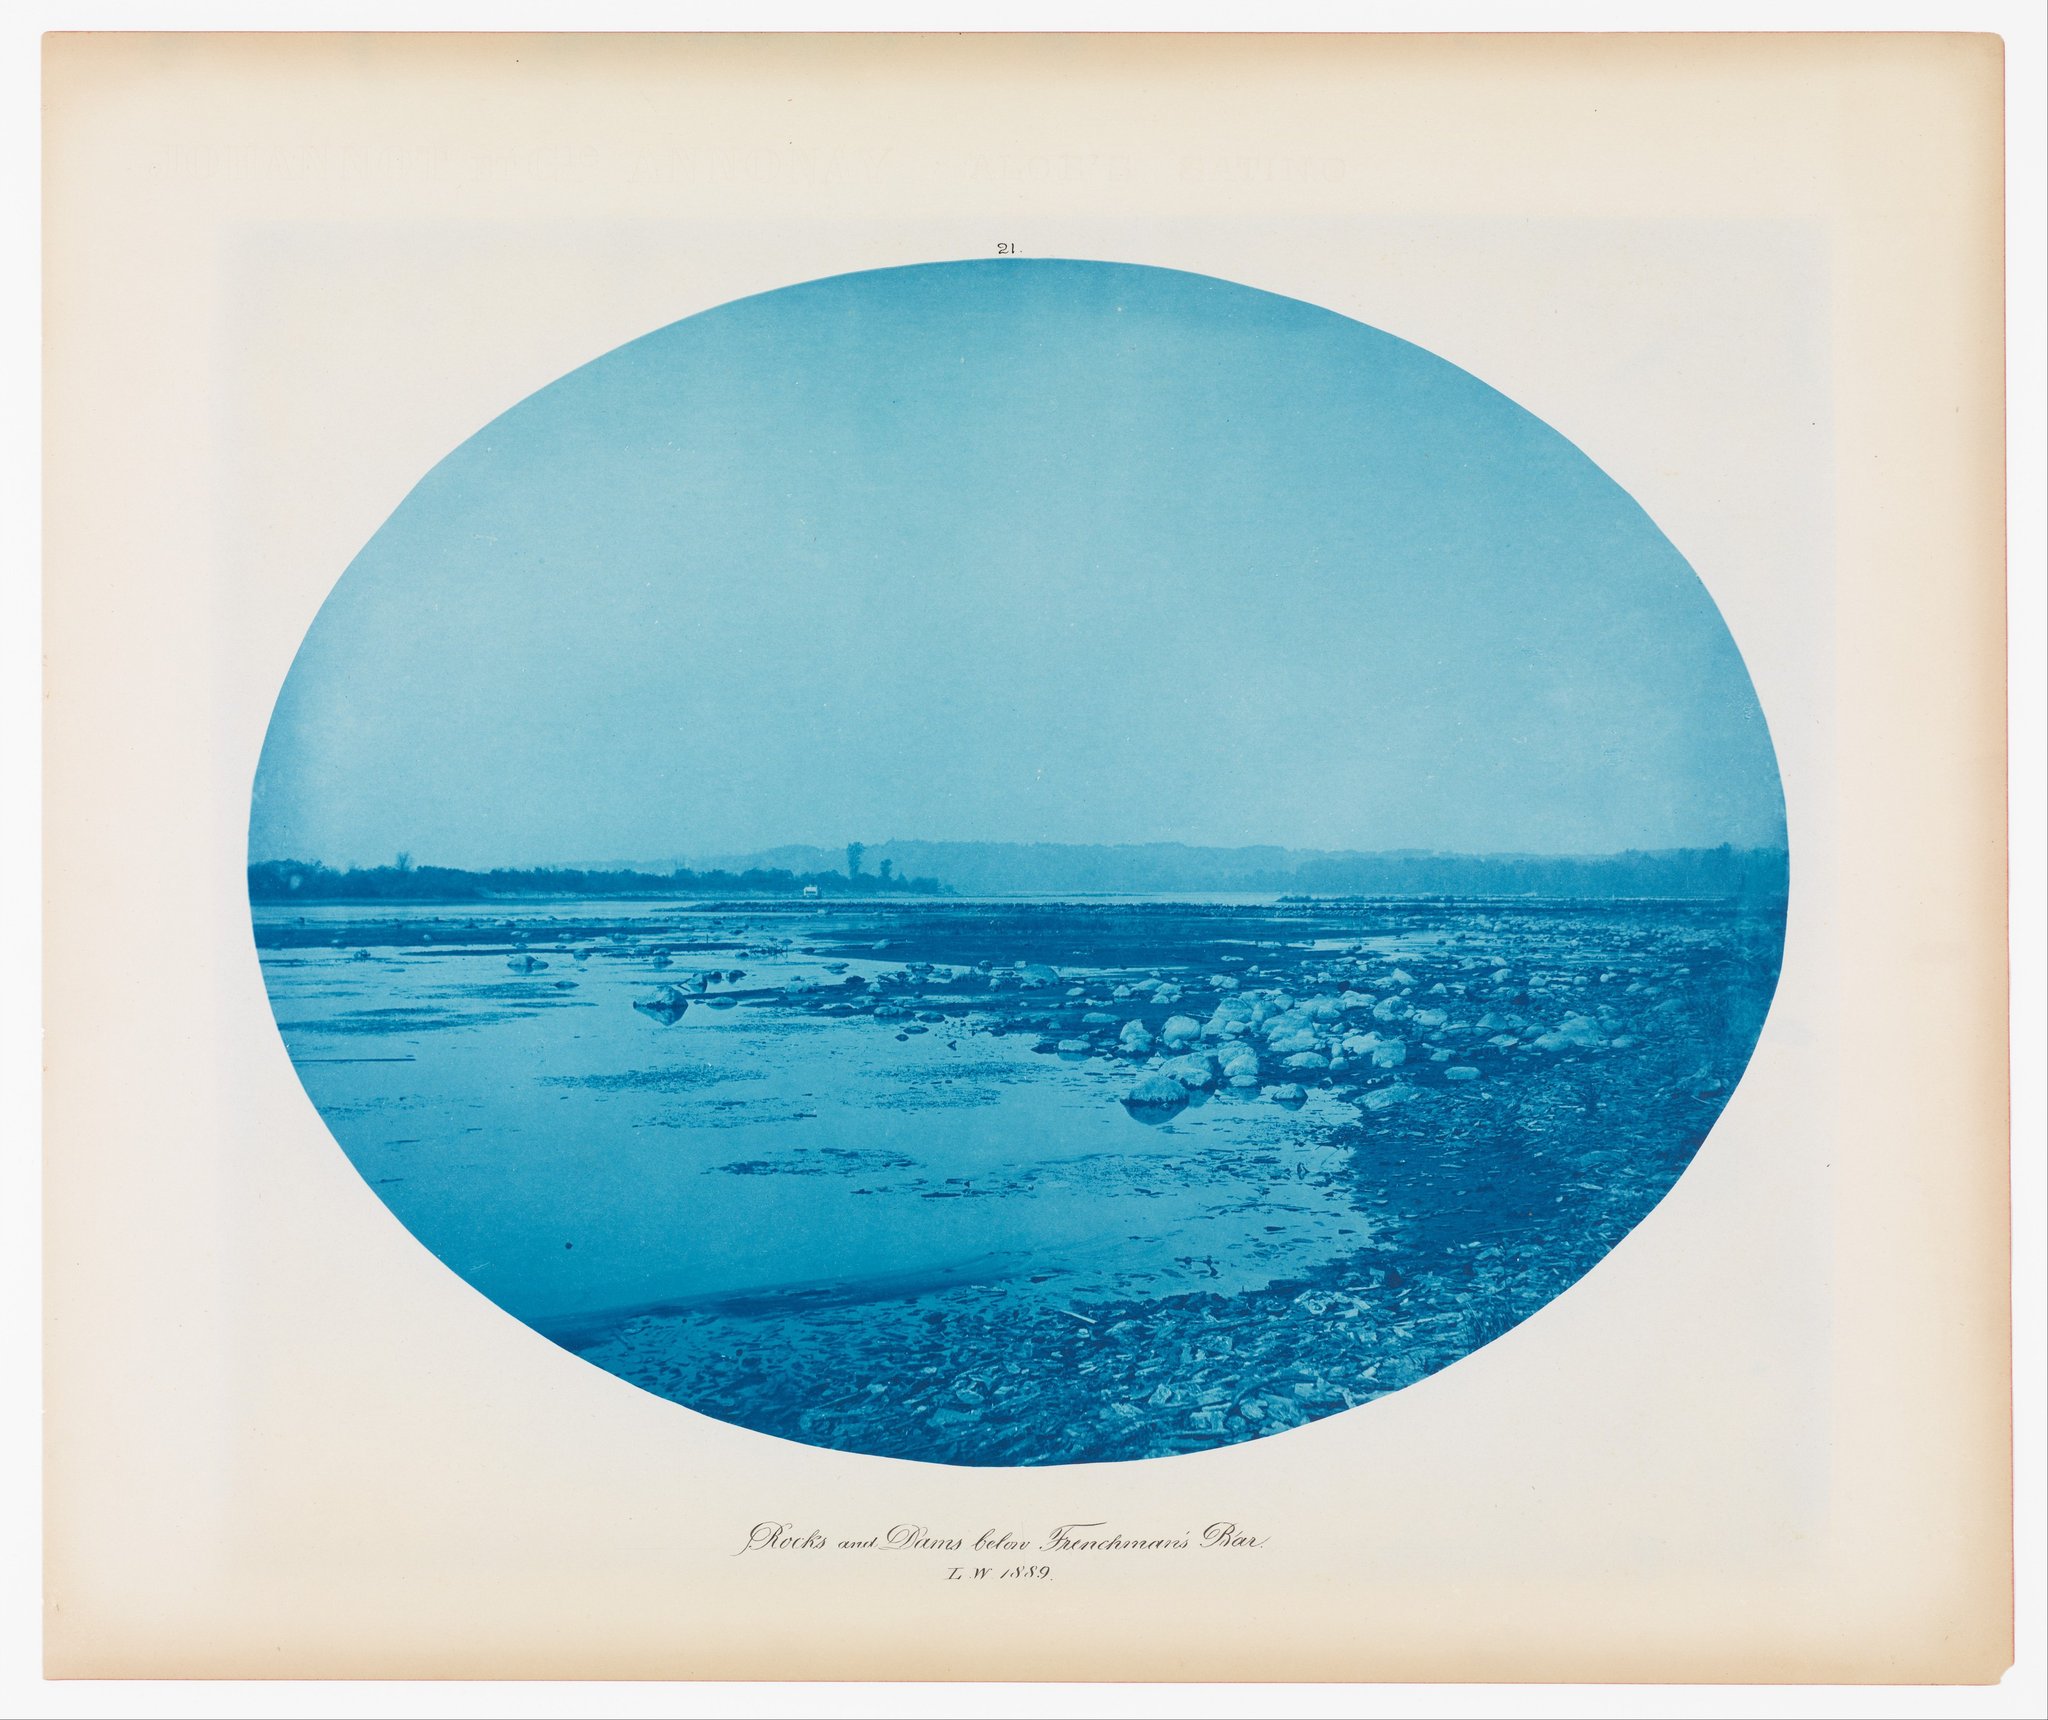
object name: photograph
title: No. 21. Rocks and Dam below Frenchmans Bar (Low Water)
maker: henry p. bosse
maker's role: artist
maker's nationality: american, born germany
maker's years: 1844-1893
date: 1889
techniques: cyanotype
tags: seascapes